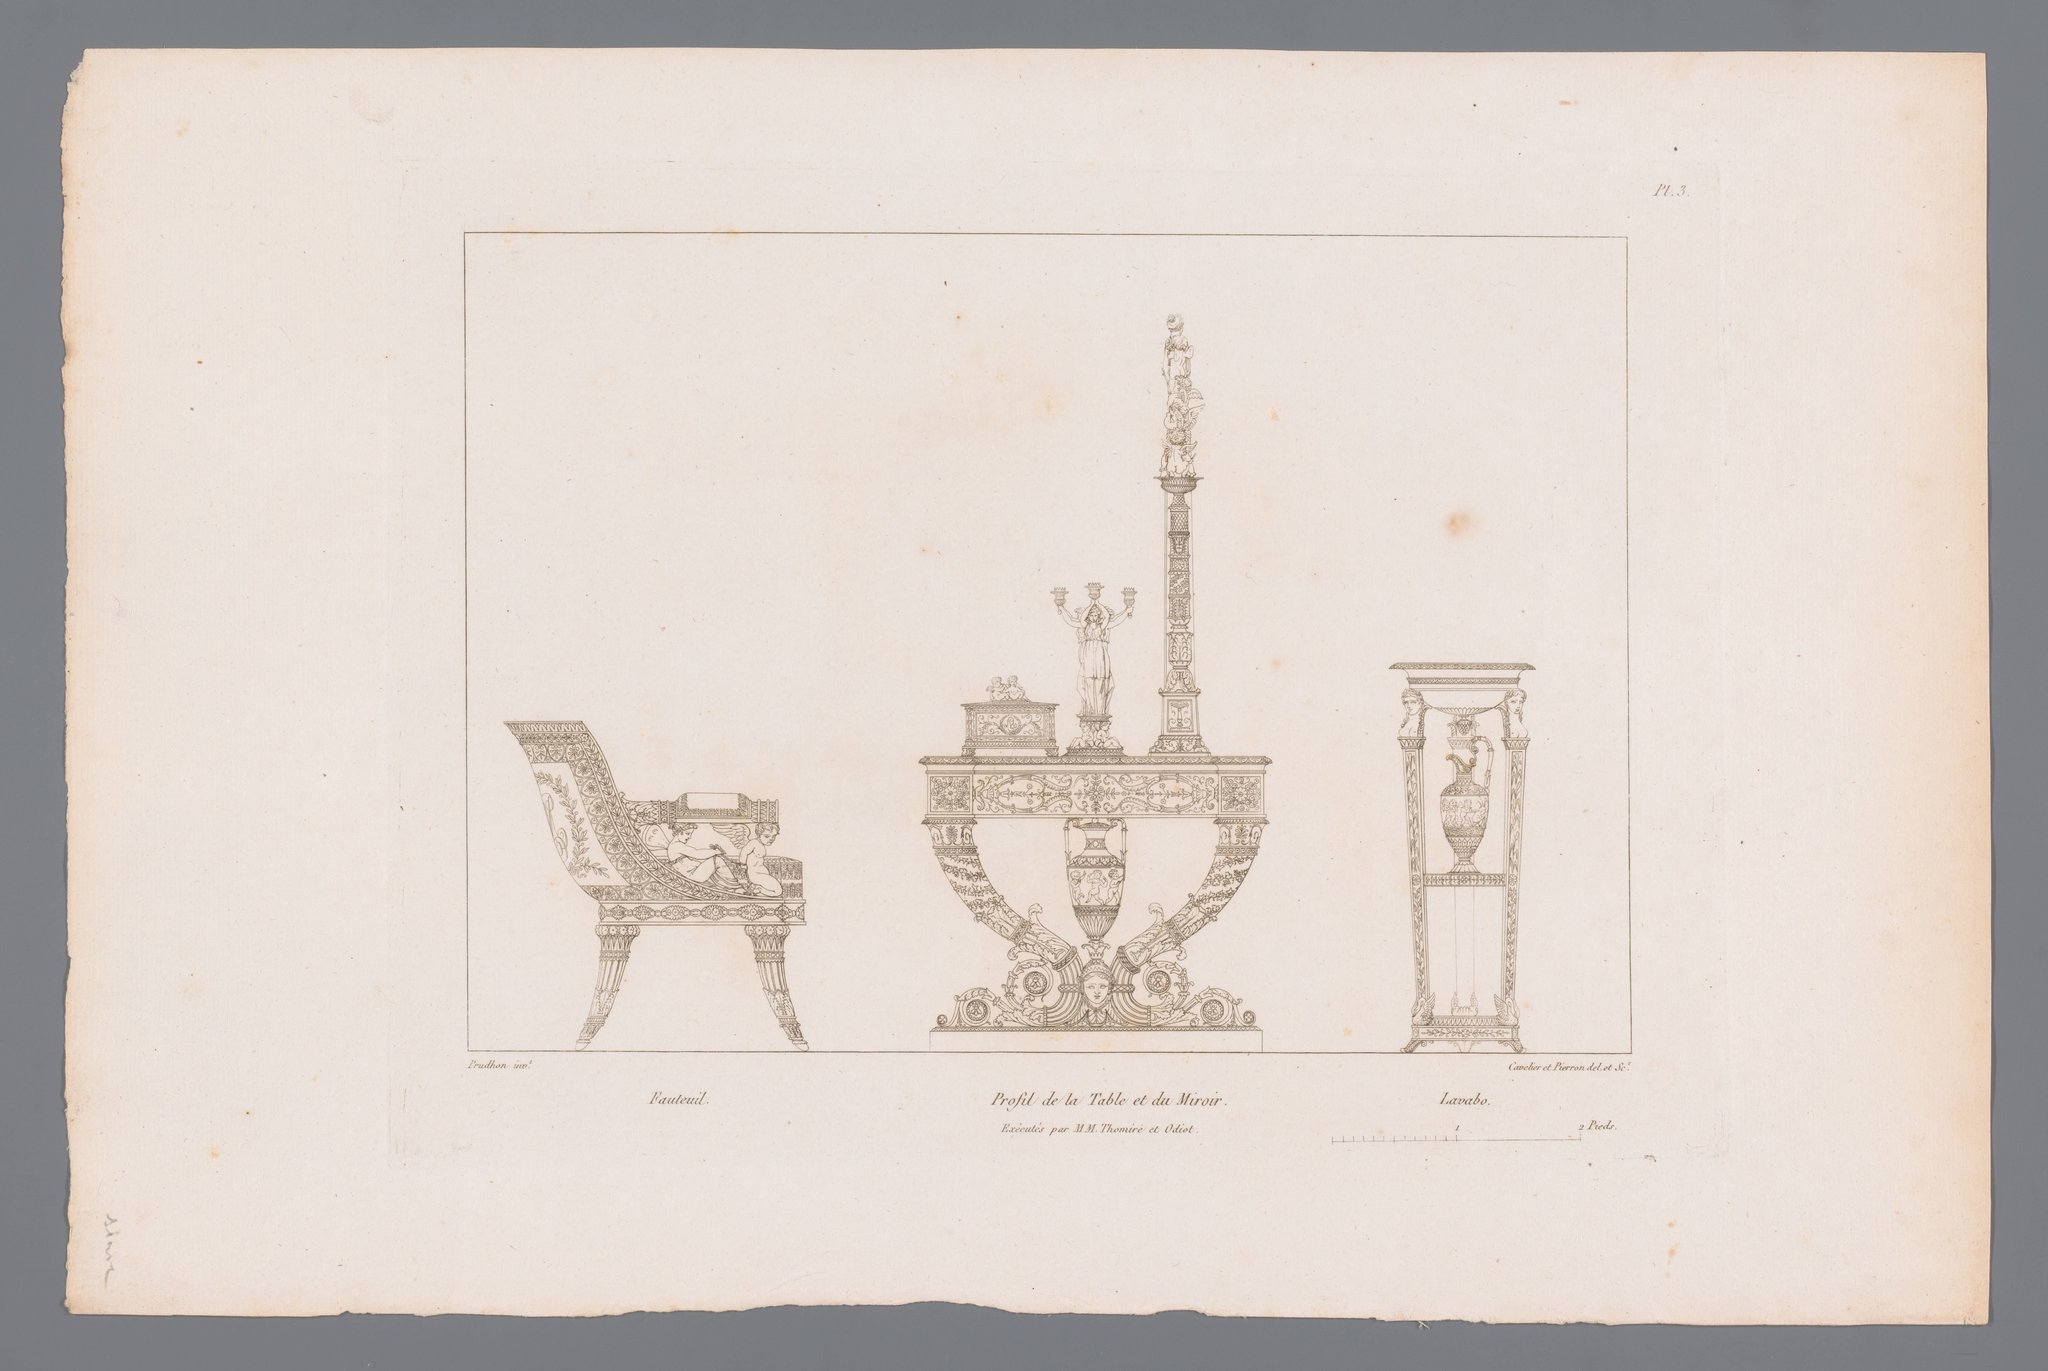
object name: print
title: Meubels geschonken aan Marie Louise van Oostenrijk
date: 1811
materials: paper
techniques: etching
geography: paris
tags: mirror, jug and basin; wash-basin, table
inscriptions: collector's mark: Lugt 2228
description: Maakt deel uit van een omslag met prenten met meubels naar ontwerp van Pierre Prud'hon. Deze meubels werden aangeboden aan Marie Louise van Oostenrijk ter gelegenheid van de geboorte van haar zoon Frans Karel Jozef Napoleon II Bonaparte.